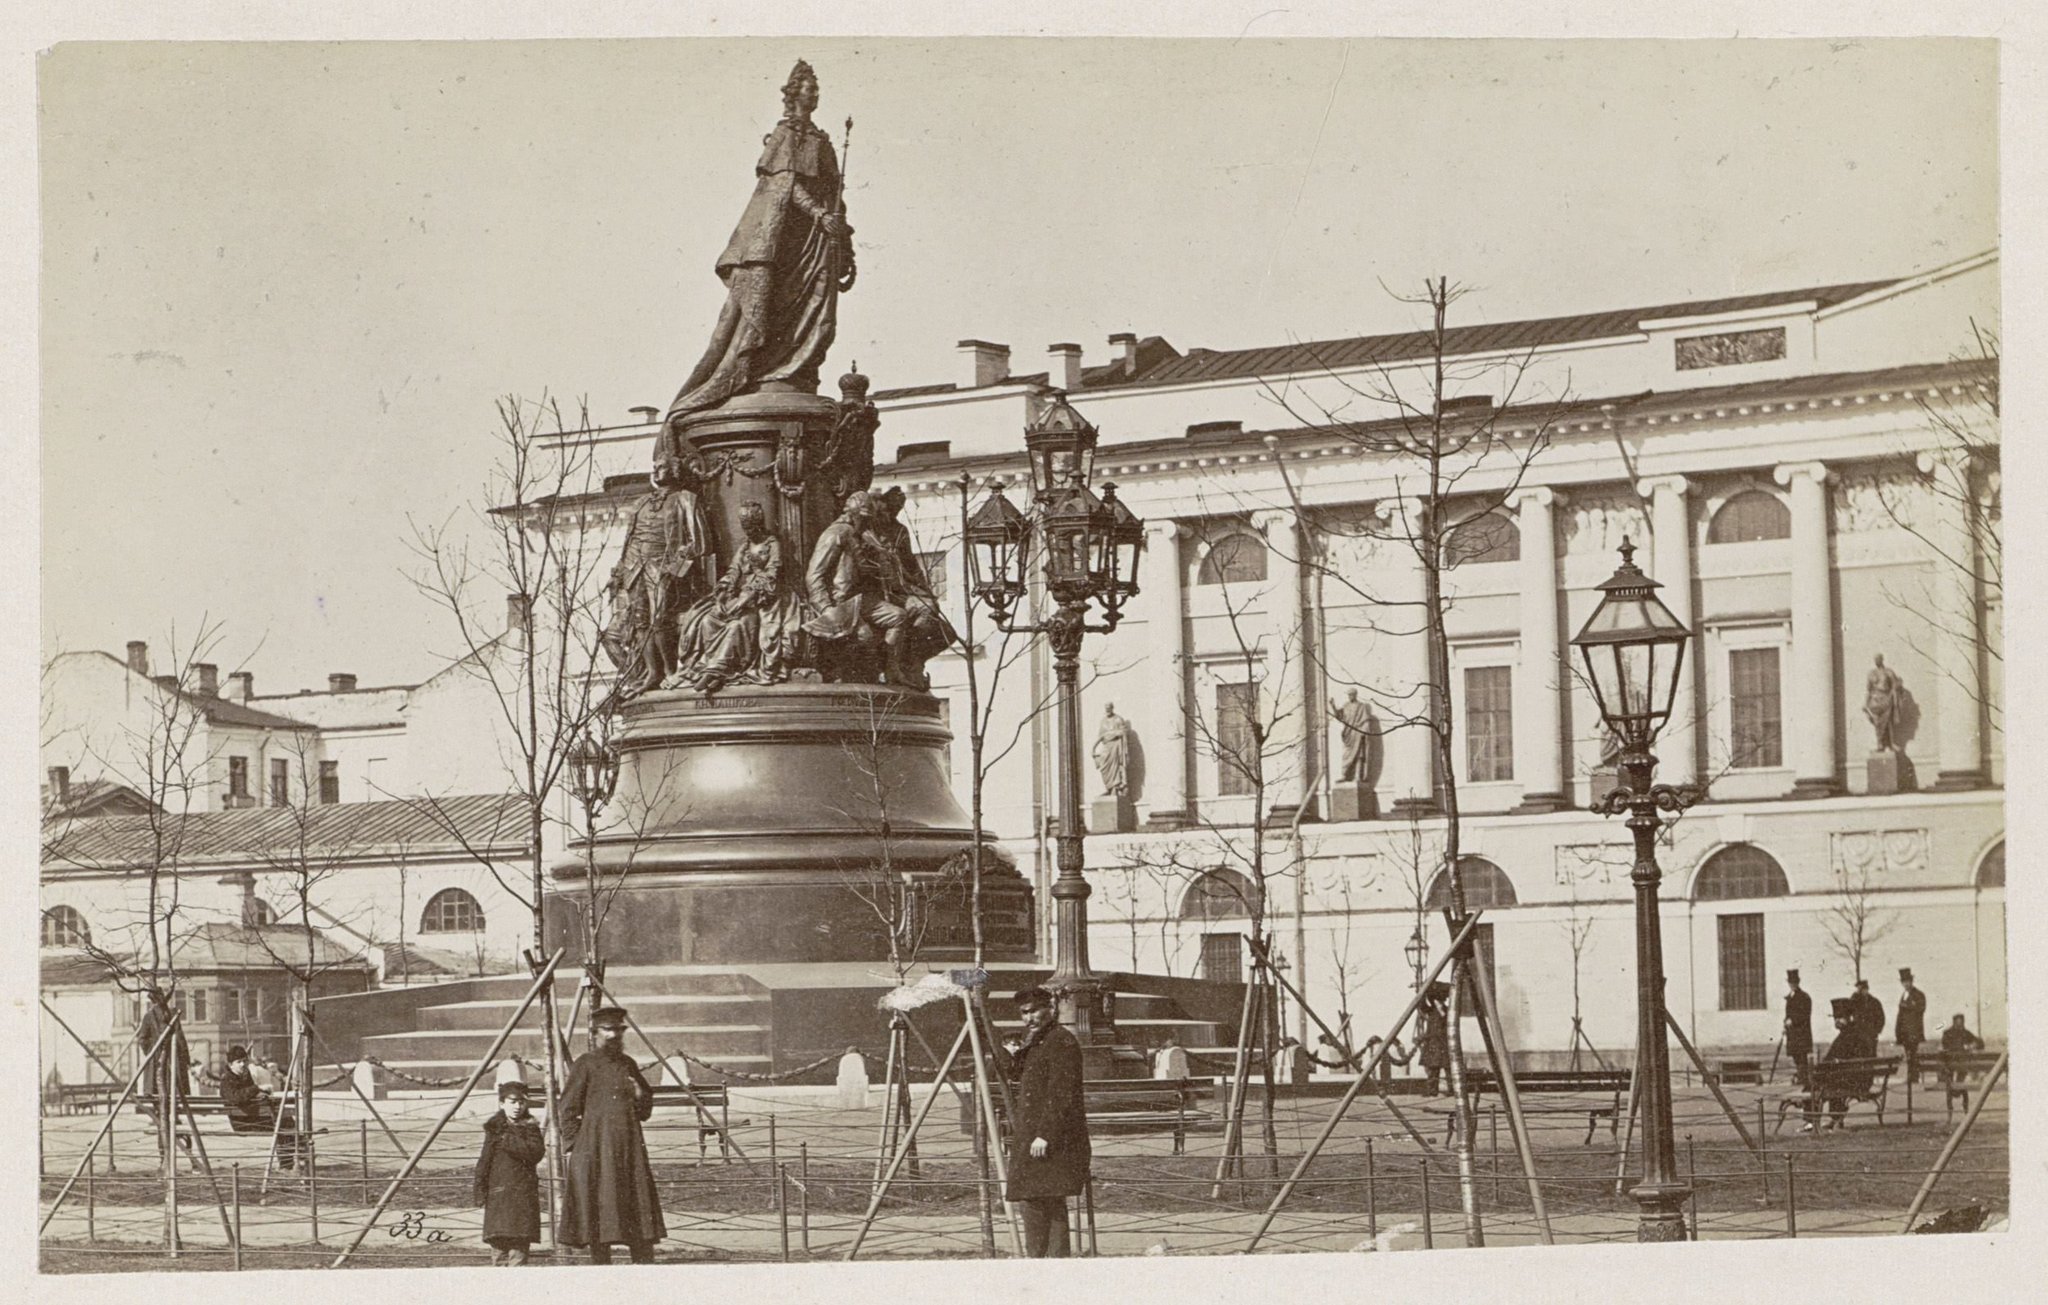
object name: photograph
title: Katurinu statyn St. Petersburg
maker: Anonymous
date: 1878-1890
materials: photographic support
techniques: albumen print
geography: sint-petersburg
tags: monument, statue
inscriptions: negative number: ‘33a’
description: Onderdeel van Reisalbum Europese steden, vermoedelijk Zweeds.